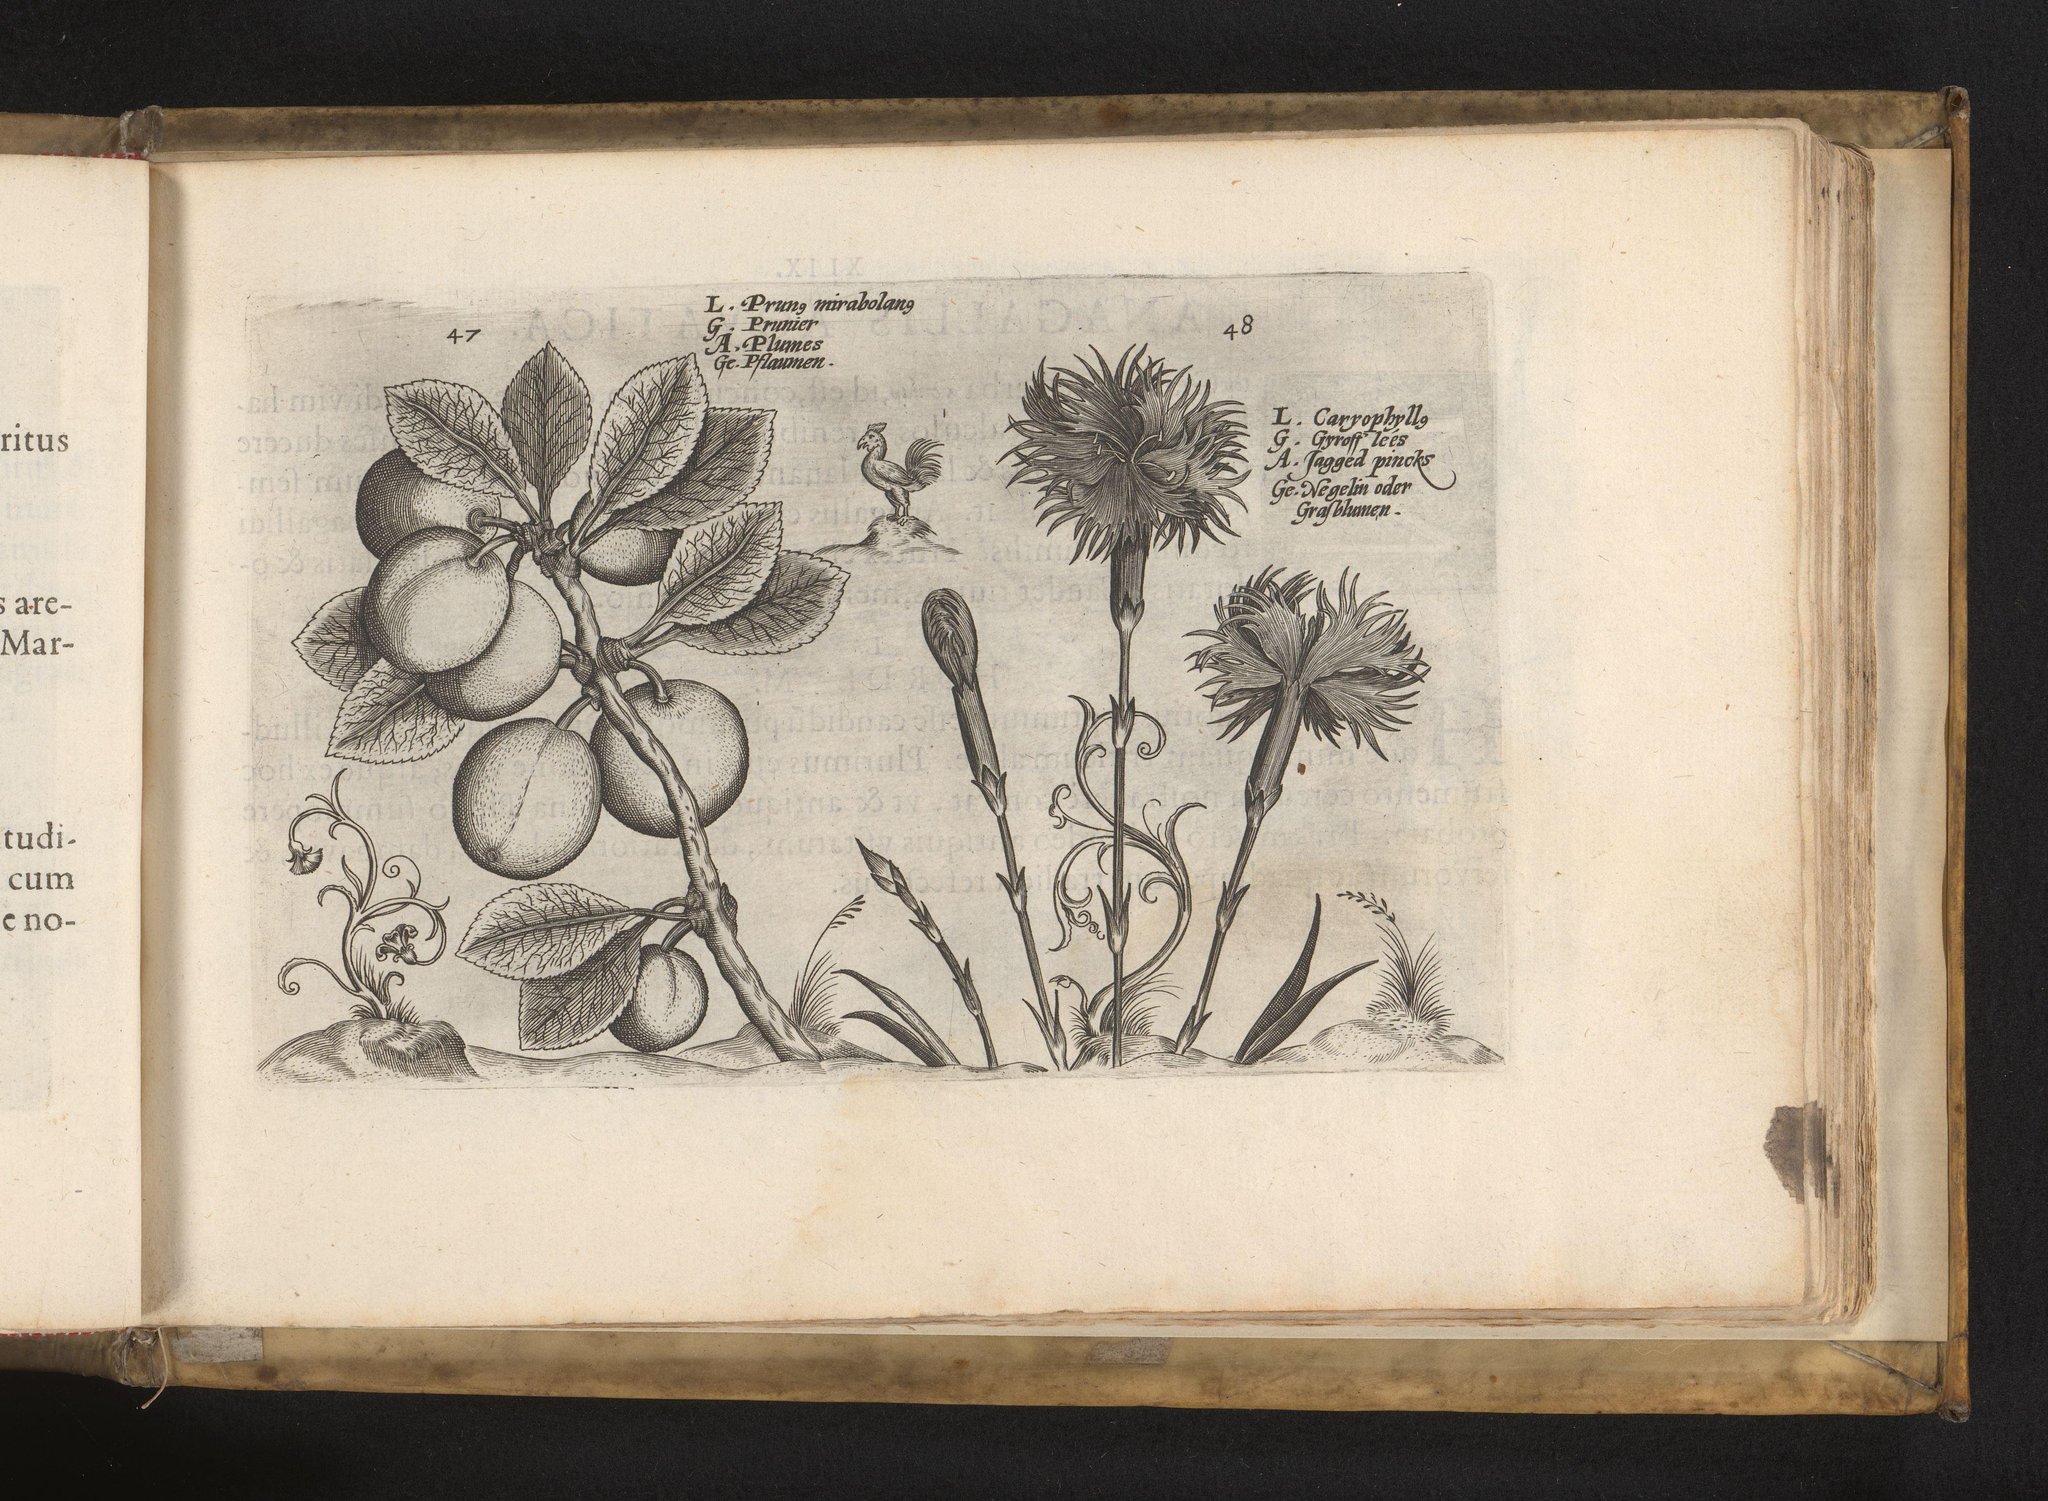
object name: book illustration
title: Prun[us] mirabolan[us] / Prunier / Plumes / Pflaumen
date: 1617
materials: paper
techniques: engraving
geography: arnhem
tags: flowers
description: Prent uit: Passe, Crispijn van de (II). Hortus floridus in quo rariorum & minus vulgarium florum icones ad vivam veramque formam. Arnhem: Johannes Janssonius, 1617.